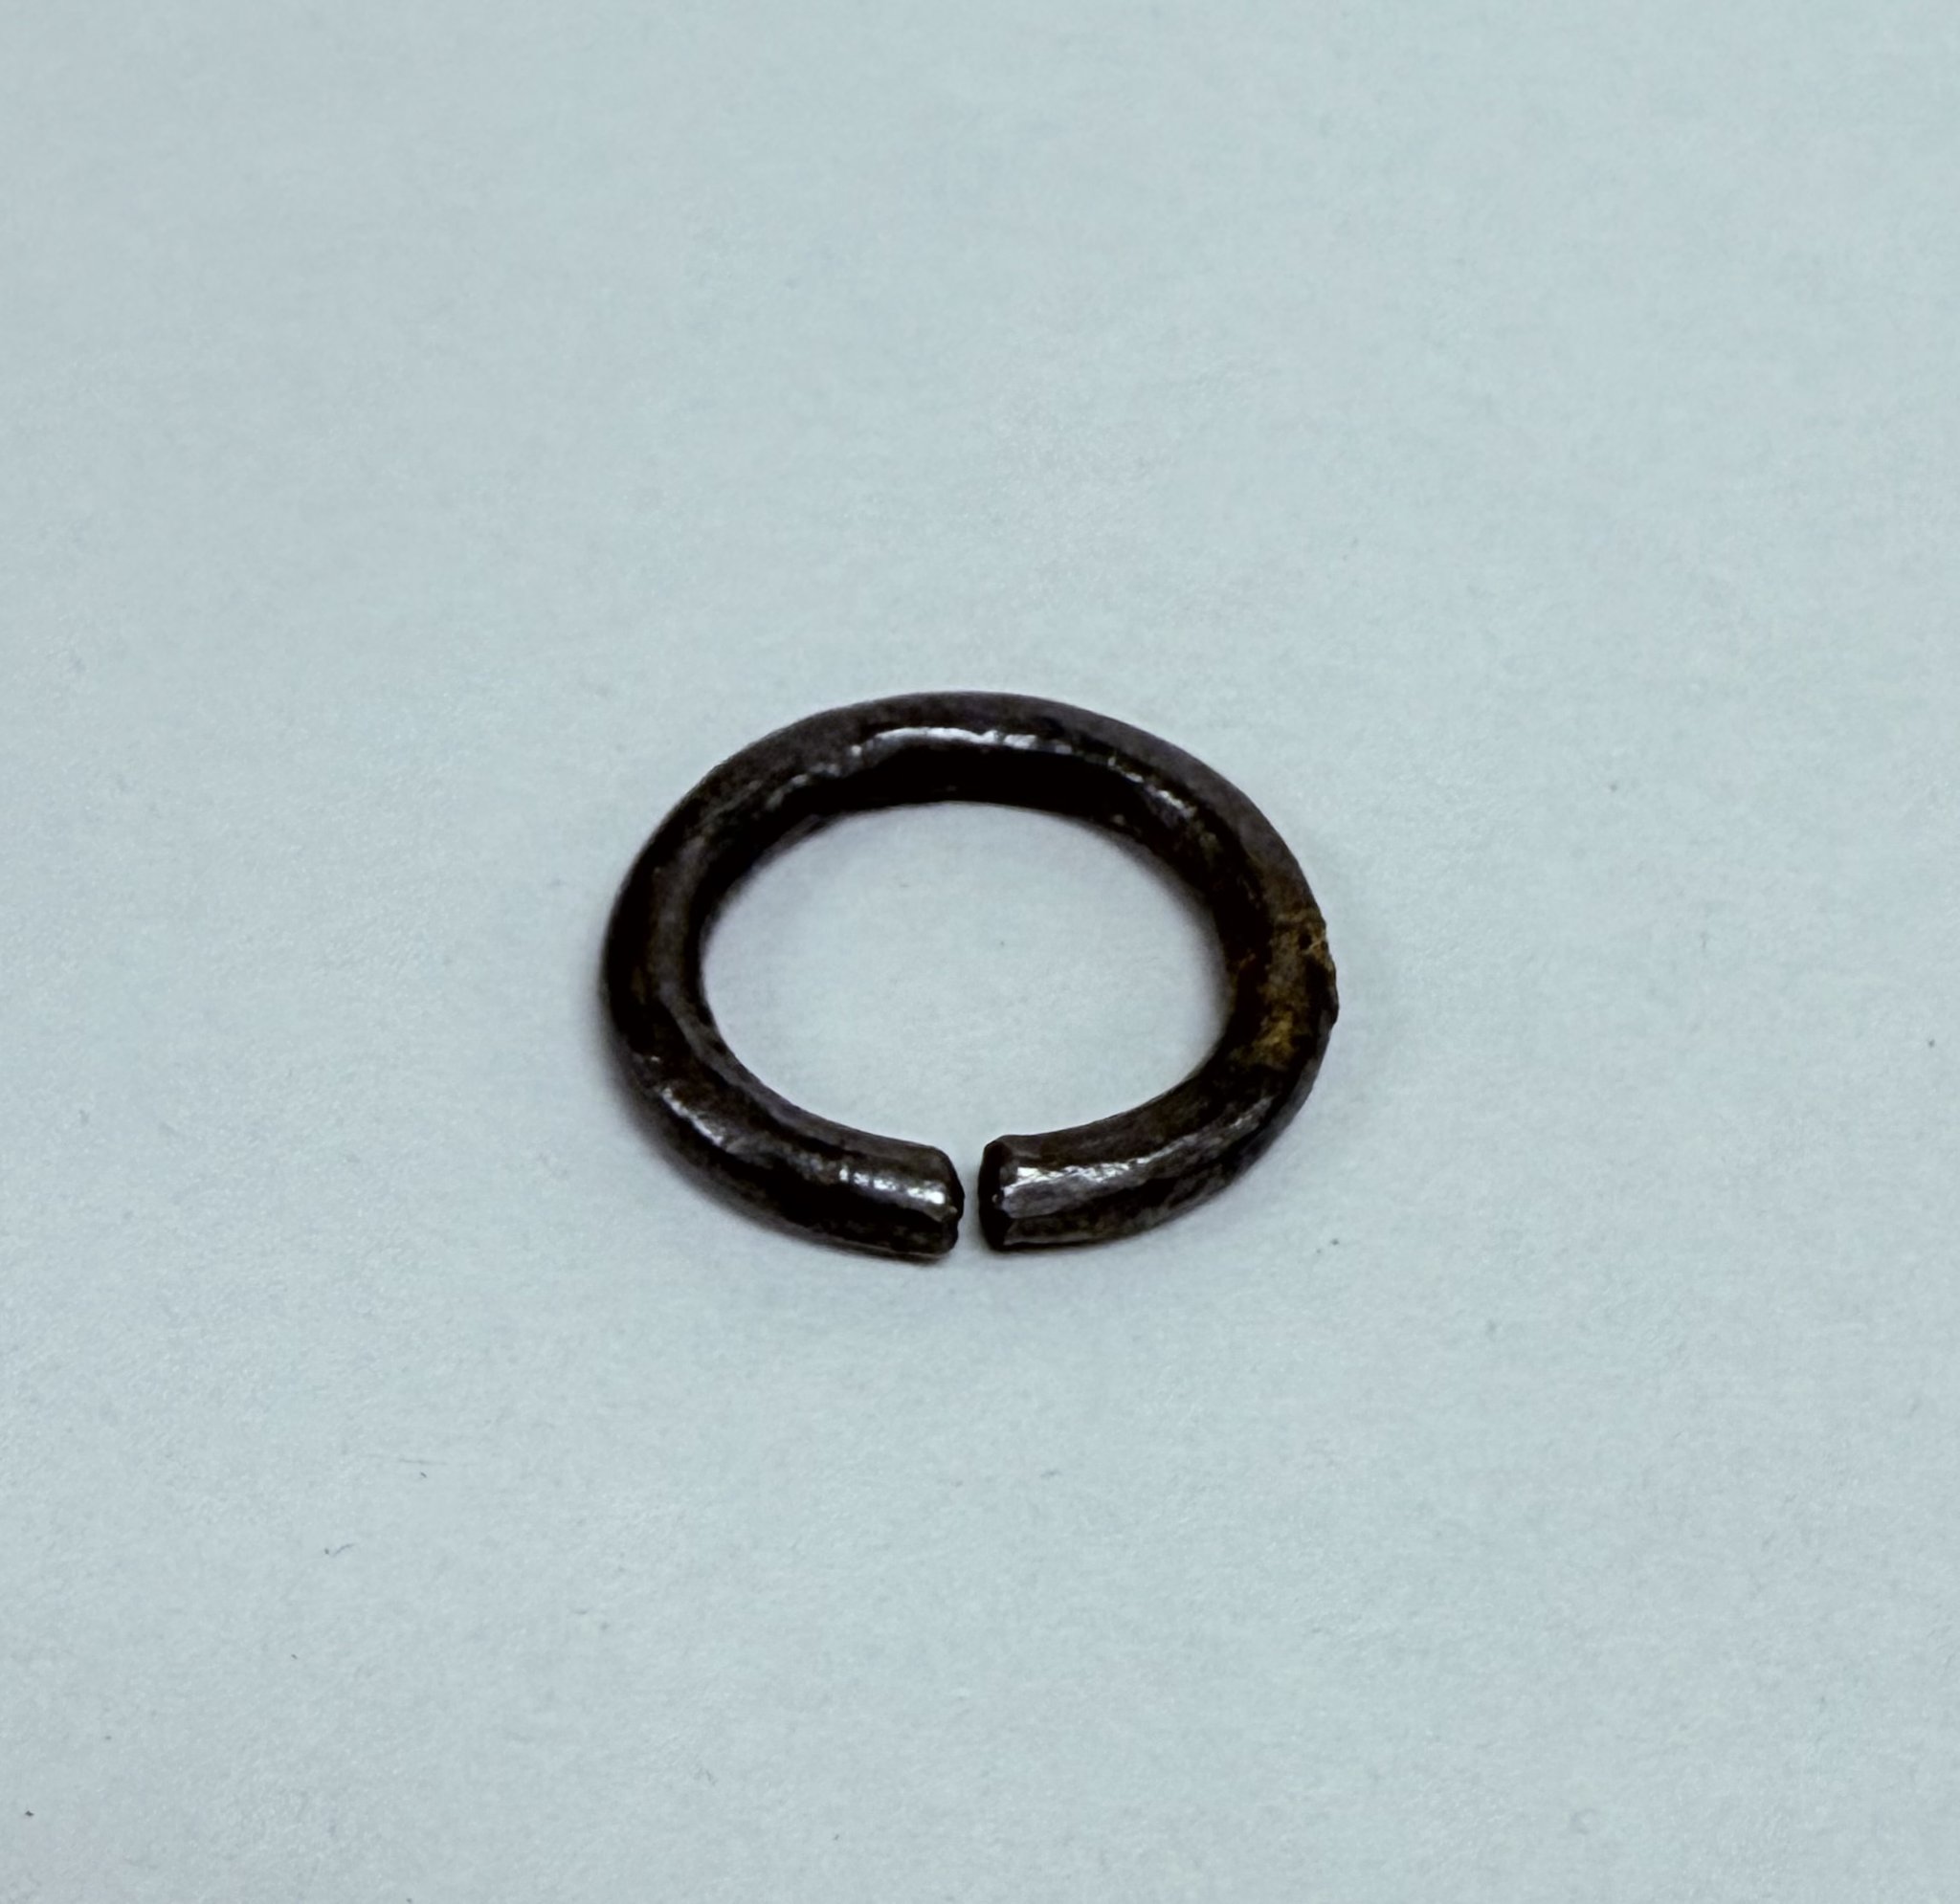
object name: earring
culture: japanese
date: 601-700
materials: silver